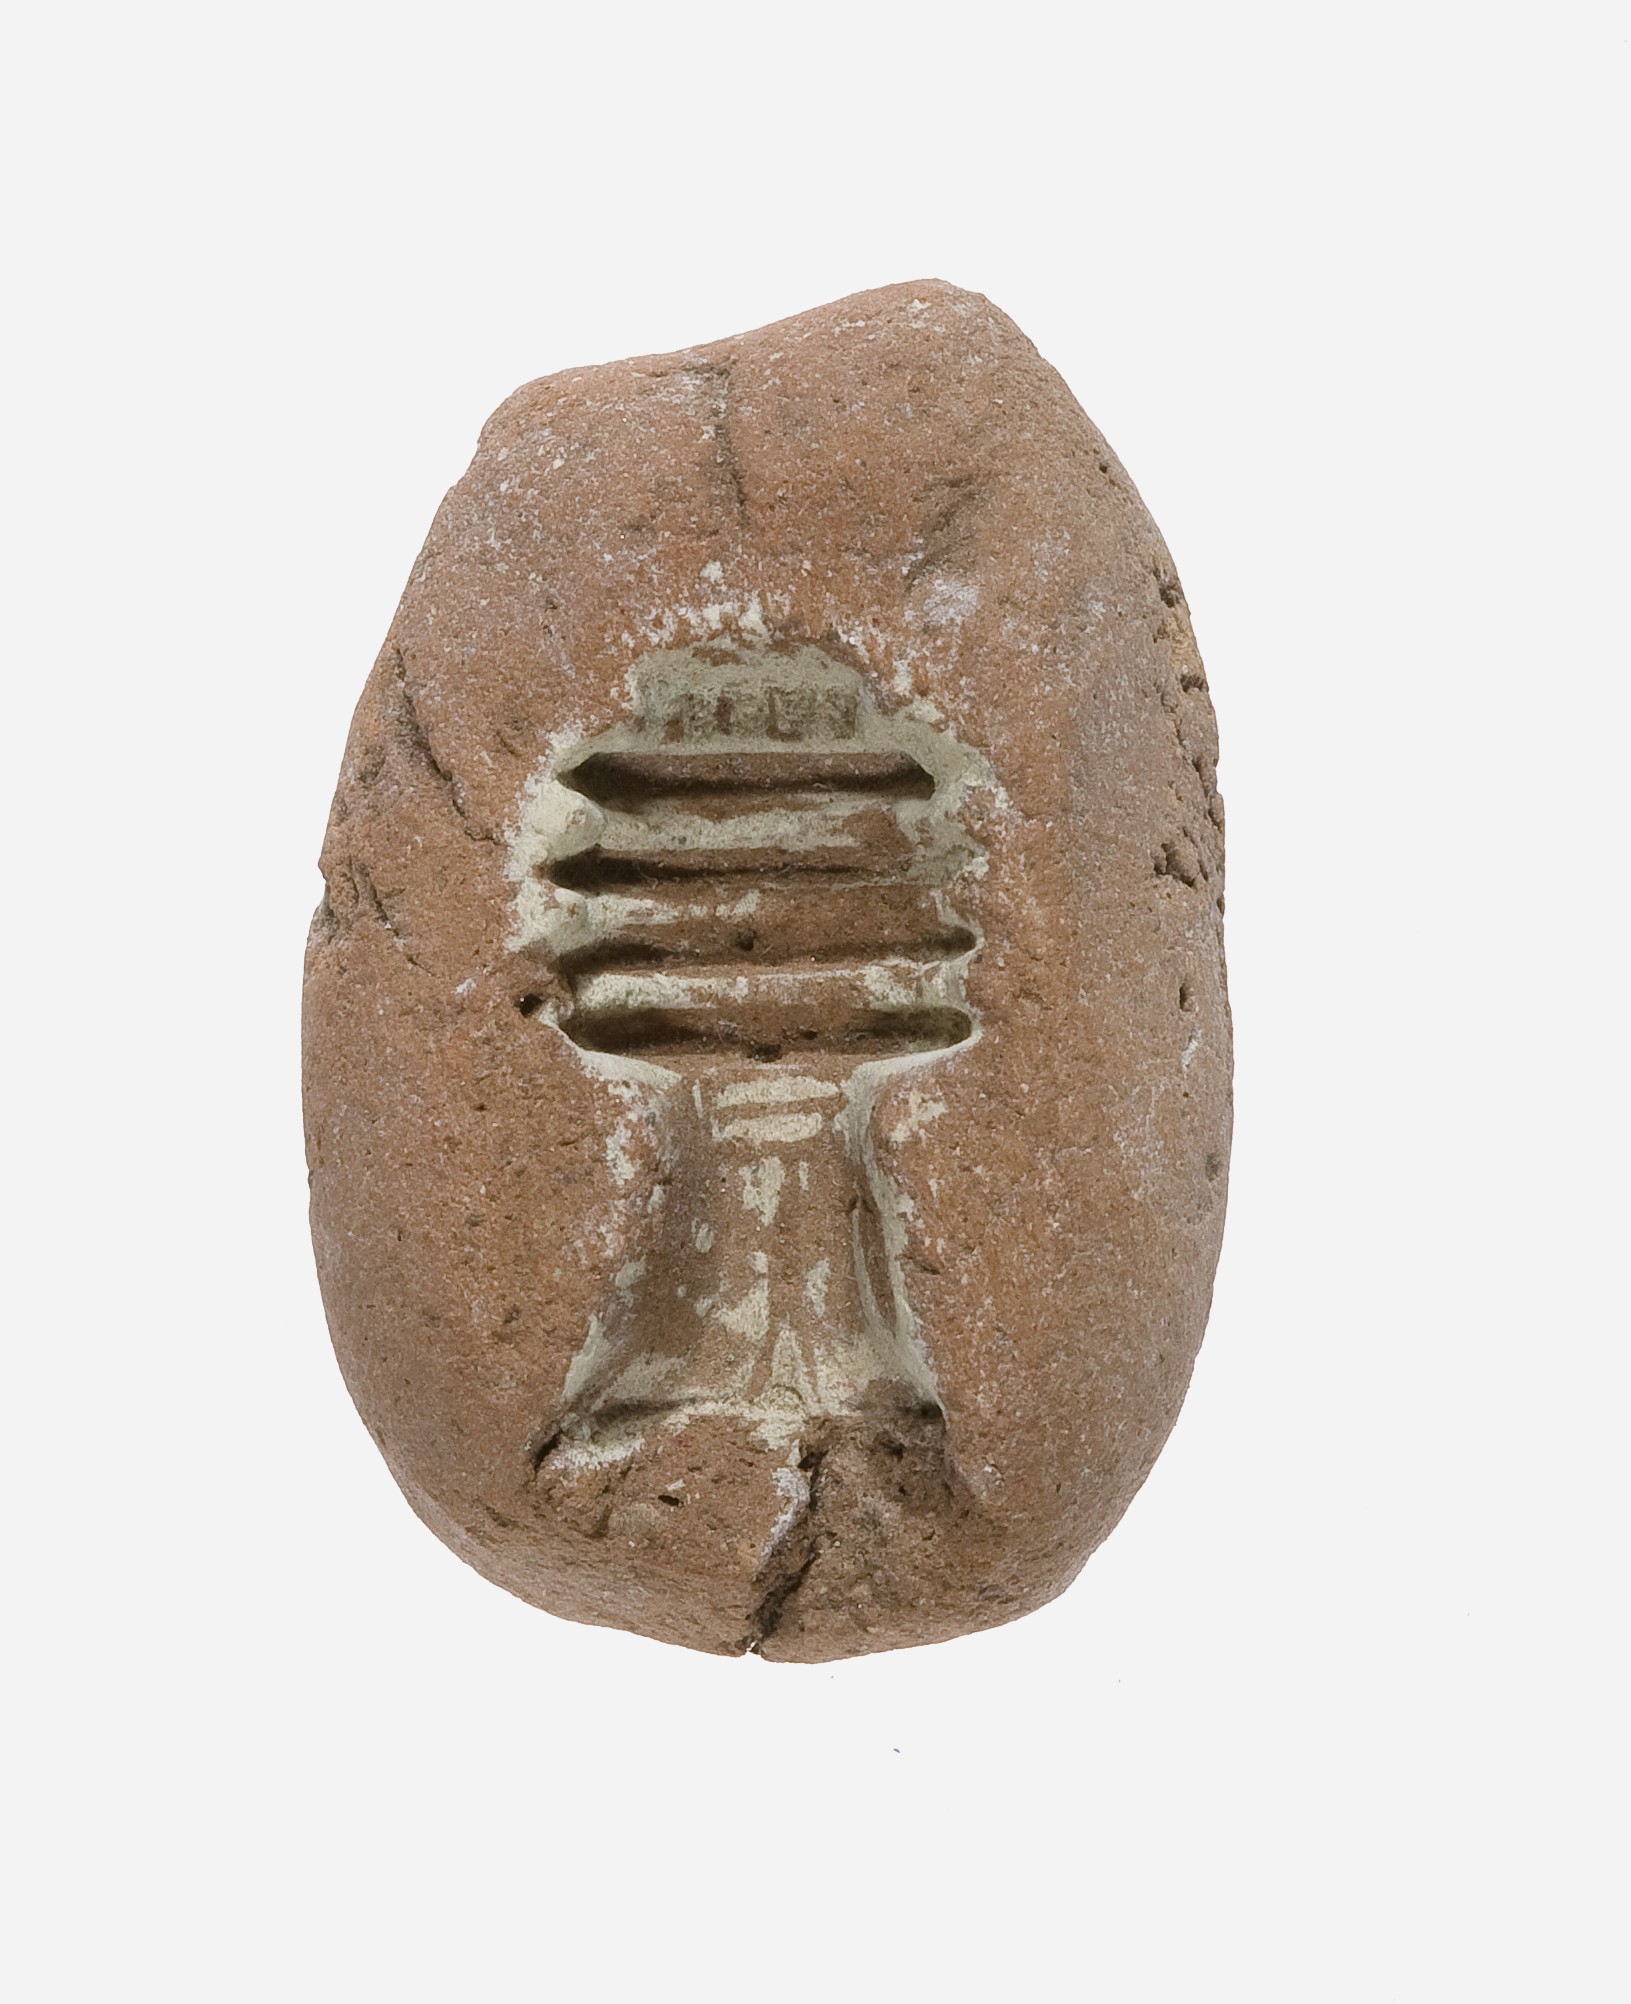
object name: mold, amulet, djed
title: Mold for a Djed Amulet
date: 1390-1352 BCE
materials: pottery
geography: egypt